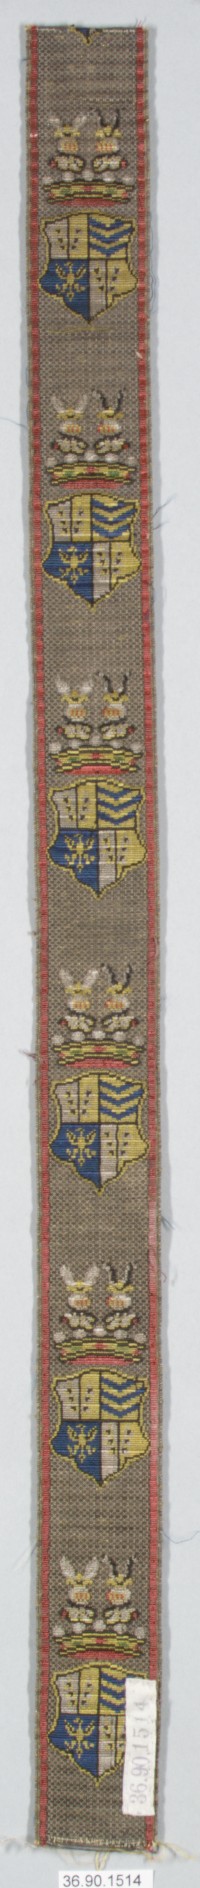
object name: galloon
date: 1701-1900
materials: silk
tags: coat of arms